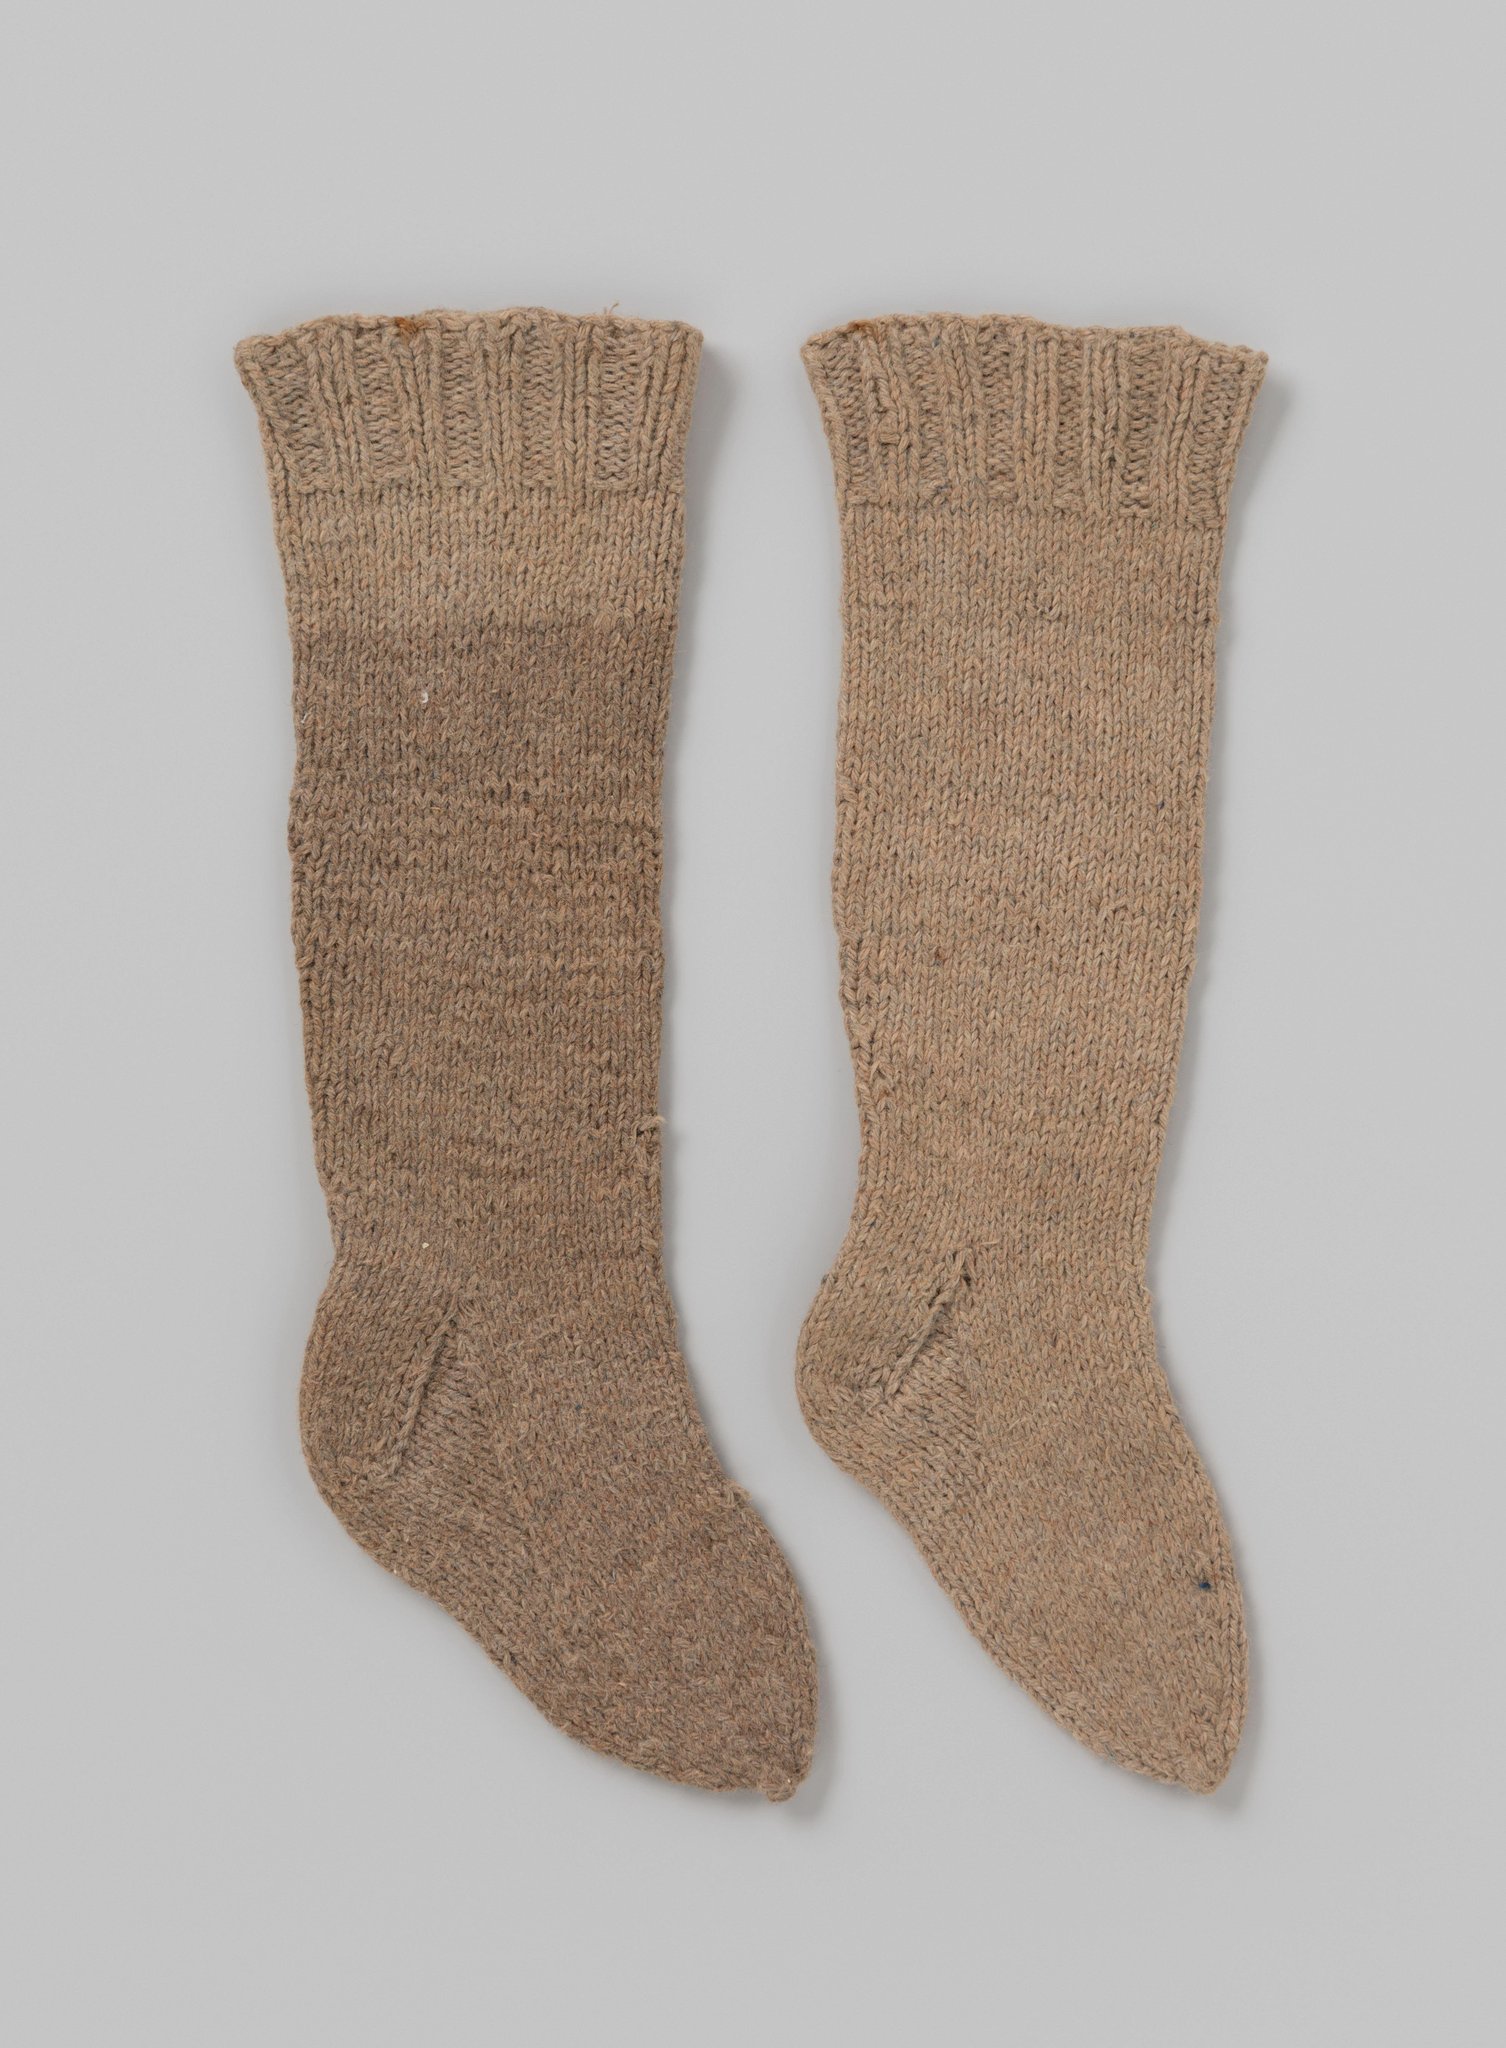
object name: childrenswear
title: Kous van effen bruine gebreide katoen, handgebreid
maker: Anonymous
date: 1879-1880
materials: cotton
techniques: knitting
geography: amsterdam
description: Kous van effen bruine gebreide katoen, handgebreid, met een smalle rechts-averechts gebreid boord.